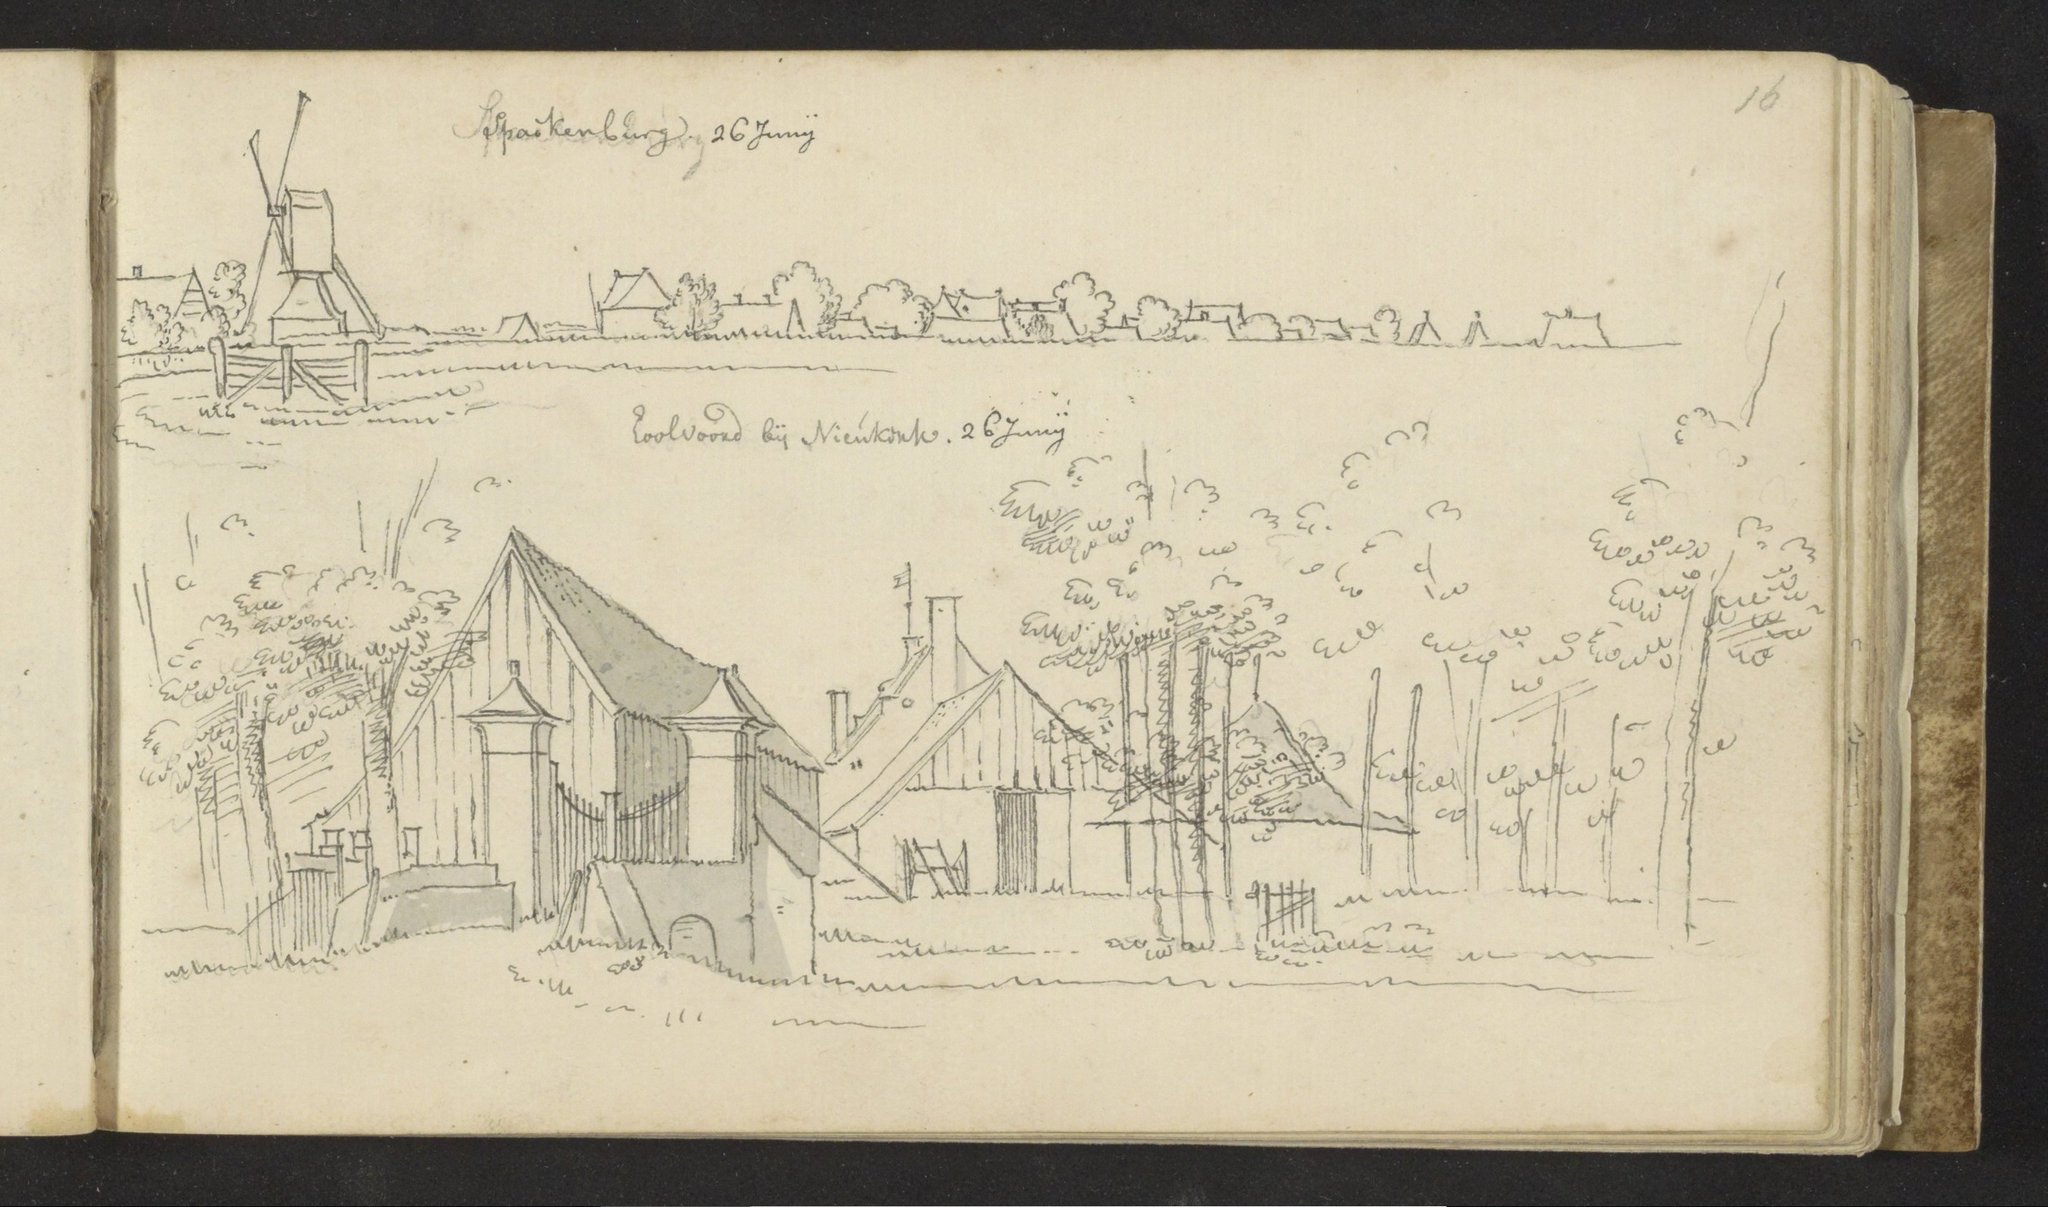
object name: sketchbook leaf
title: Gezicht op Spakenburg en Hoolvoord bij Nijkerk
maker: abraham de haen (ii)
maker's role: draughtsman, print maker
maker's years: 1707-1748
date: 1732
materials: ink, paper, pencil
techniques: brush, pen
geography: spakenburg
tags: prospect of village, silhouette of village, farm (building)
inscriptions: date and inscription: ‘Spaekenburg 26 junij/ Hoolvoord bij Nieukerke. 26 junij’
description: Blad 16 recto uit een schetsboek met 51 bladen.